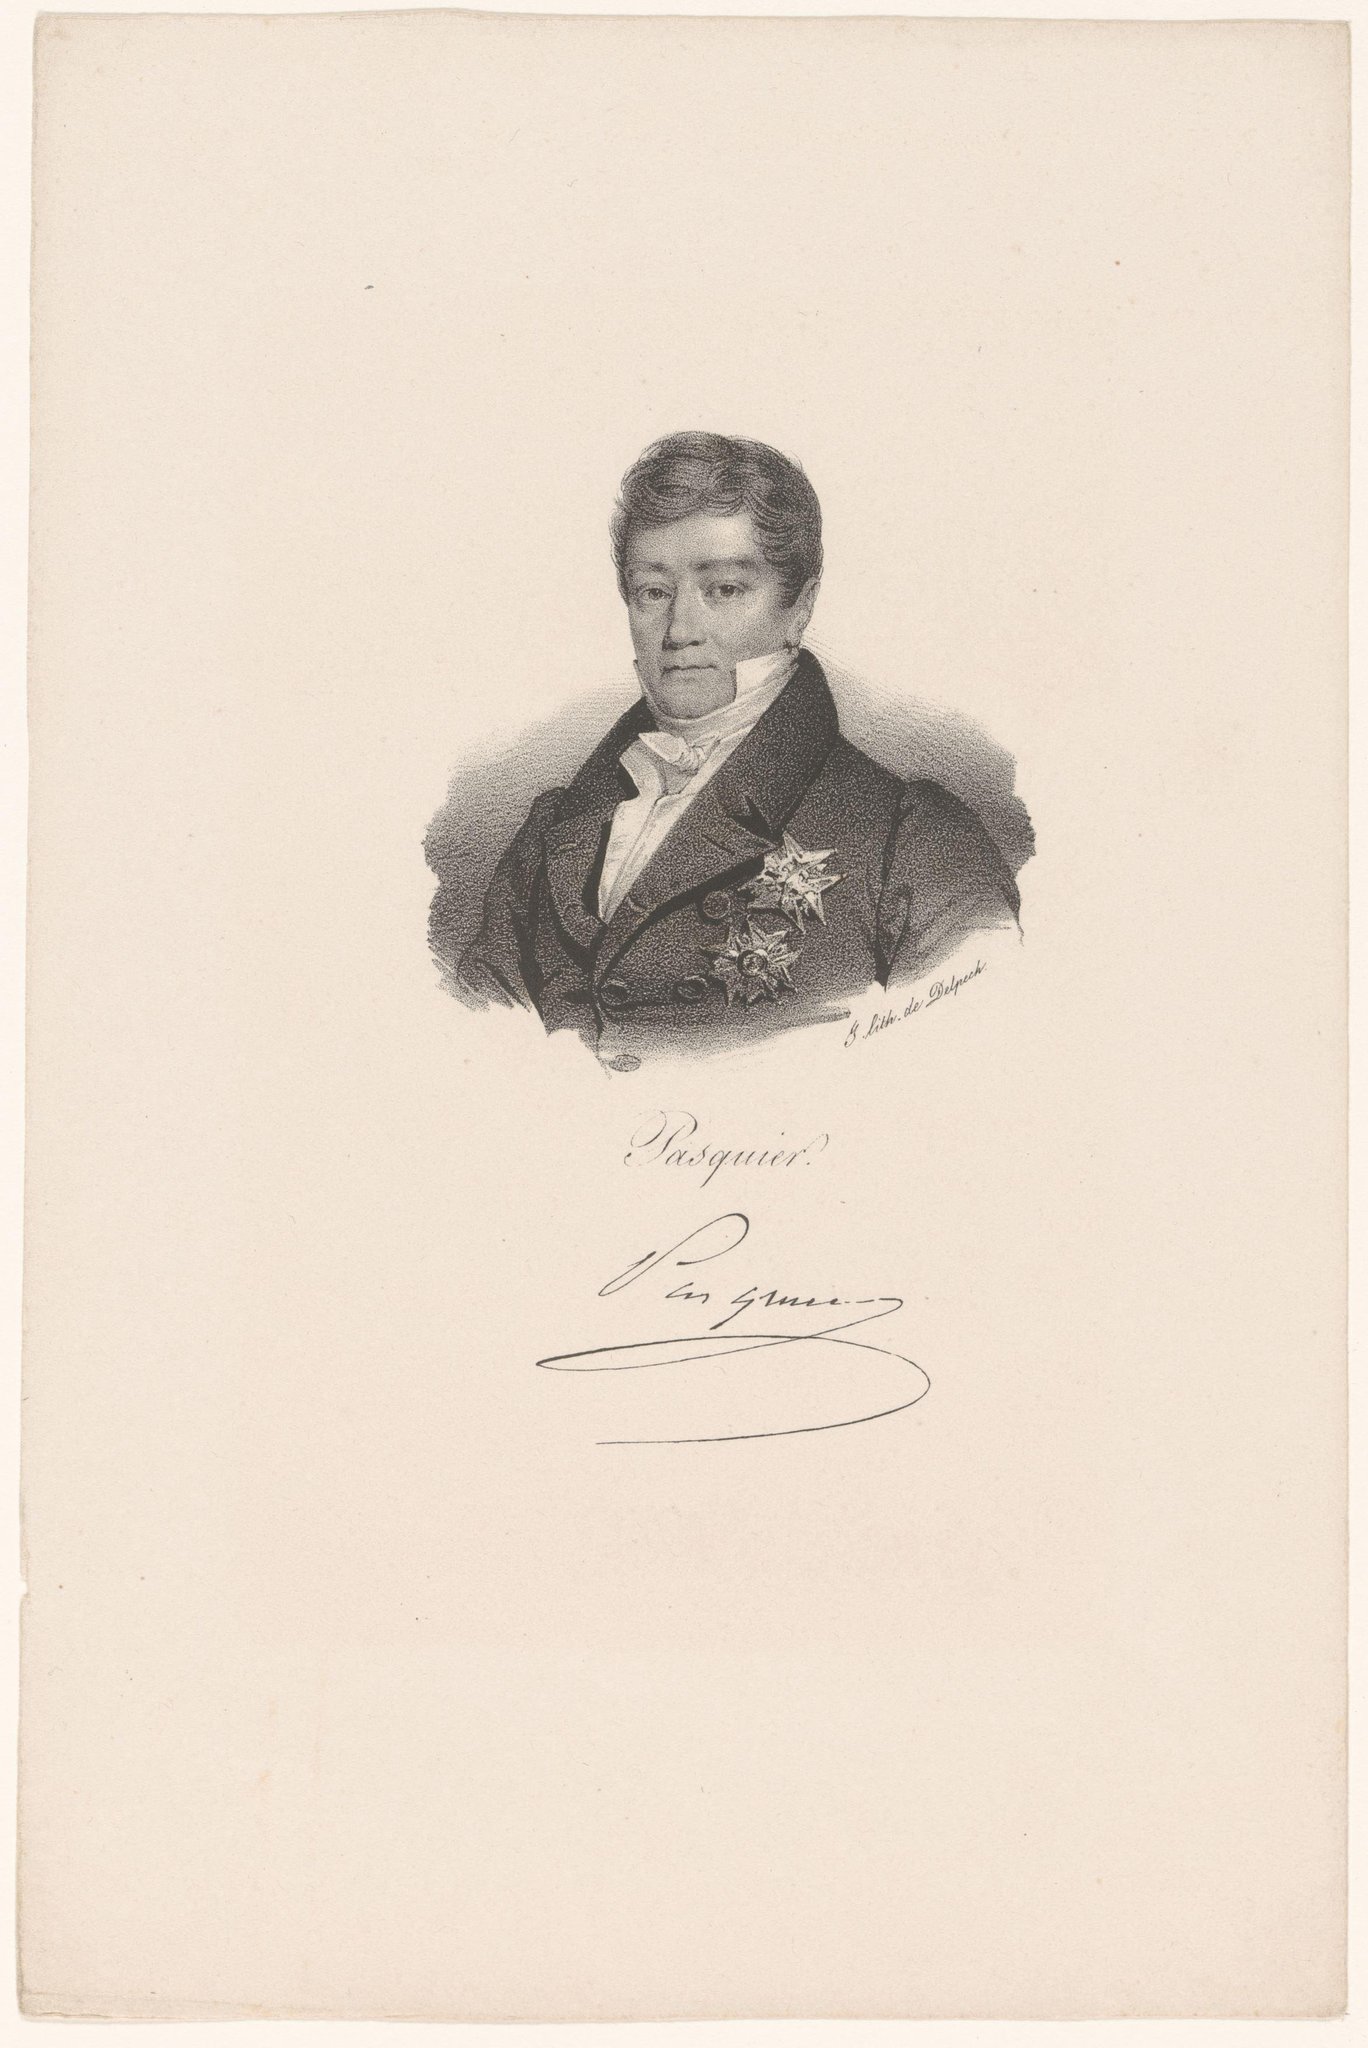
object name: print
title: Portret van Étienne-Denis Pasquier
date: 1818-1842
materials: paper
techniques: lithograph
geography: paris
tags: paris, politician, historical persons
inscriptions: collector's mark: Lugt 2228a